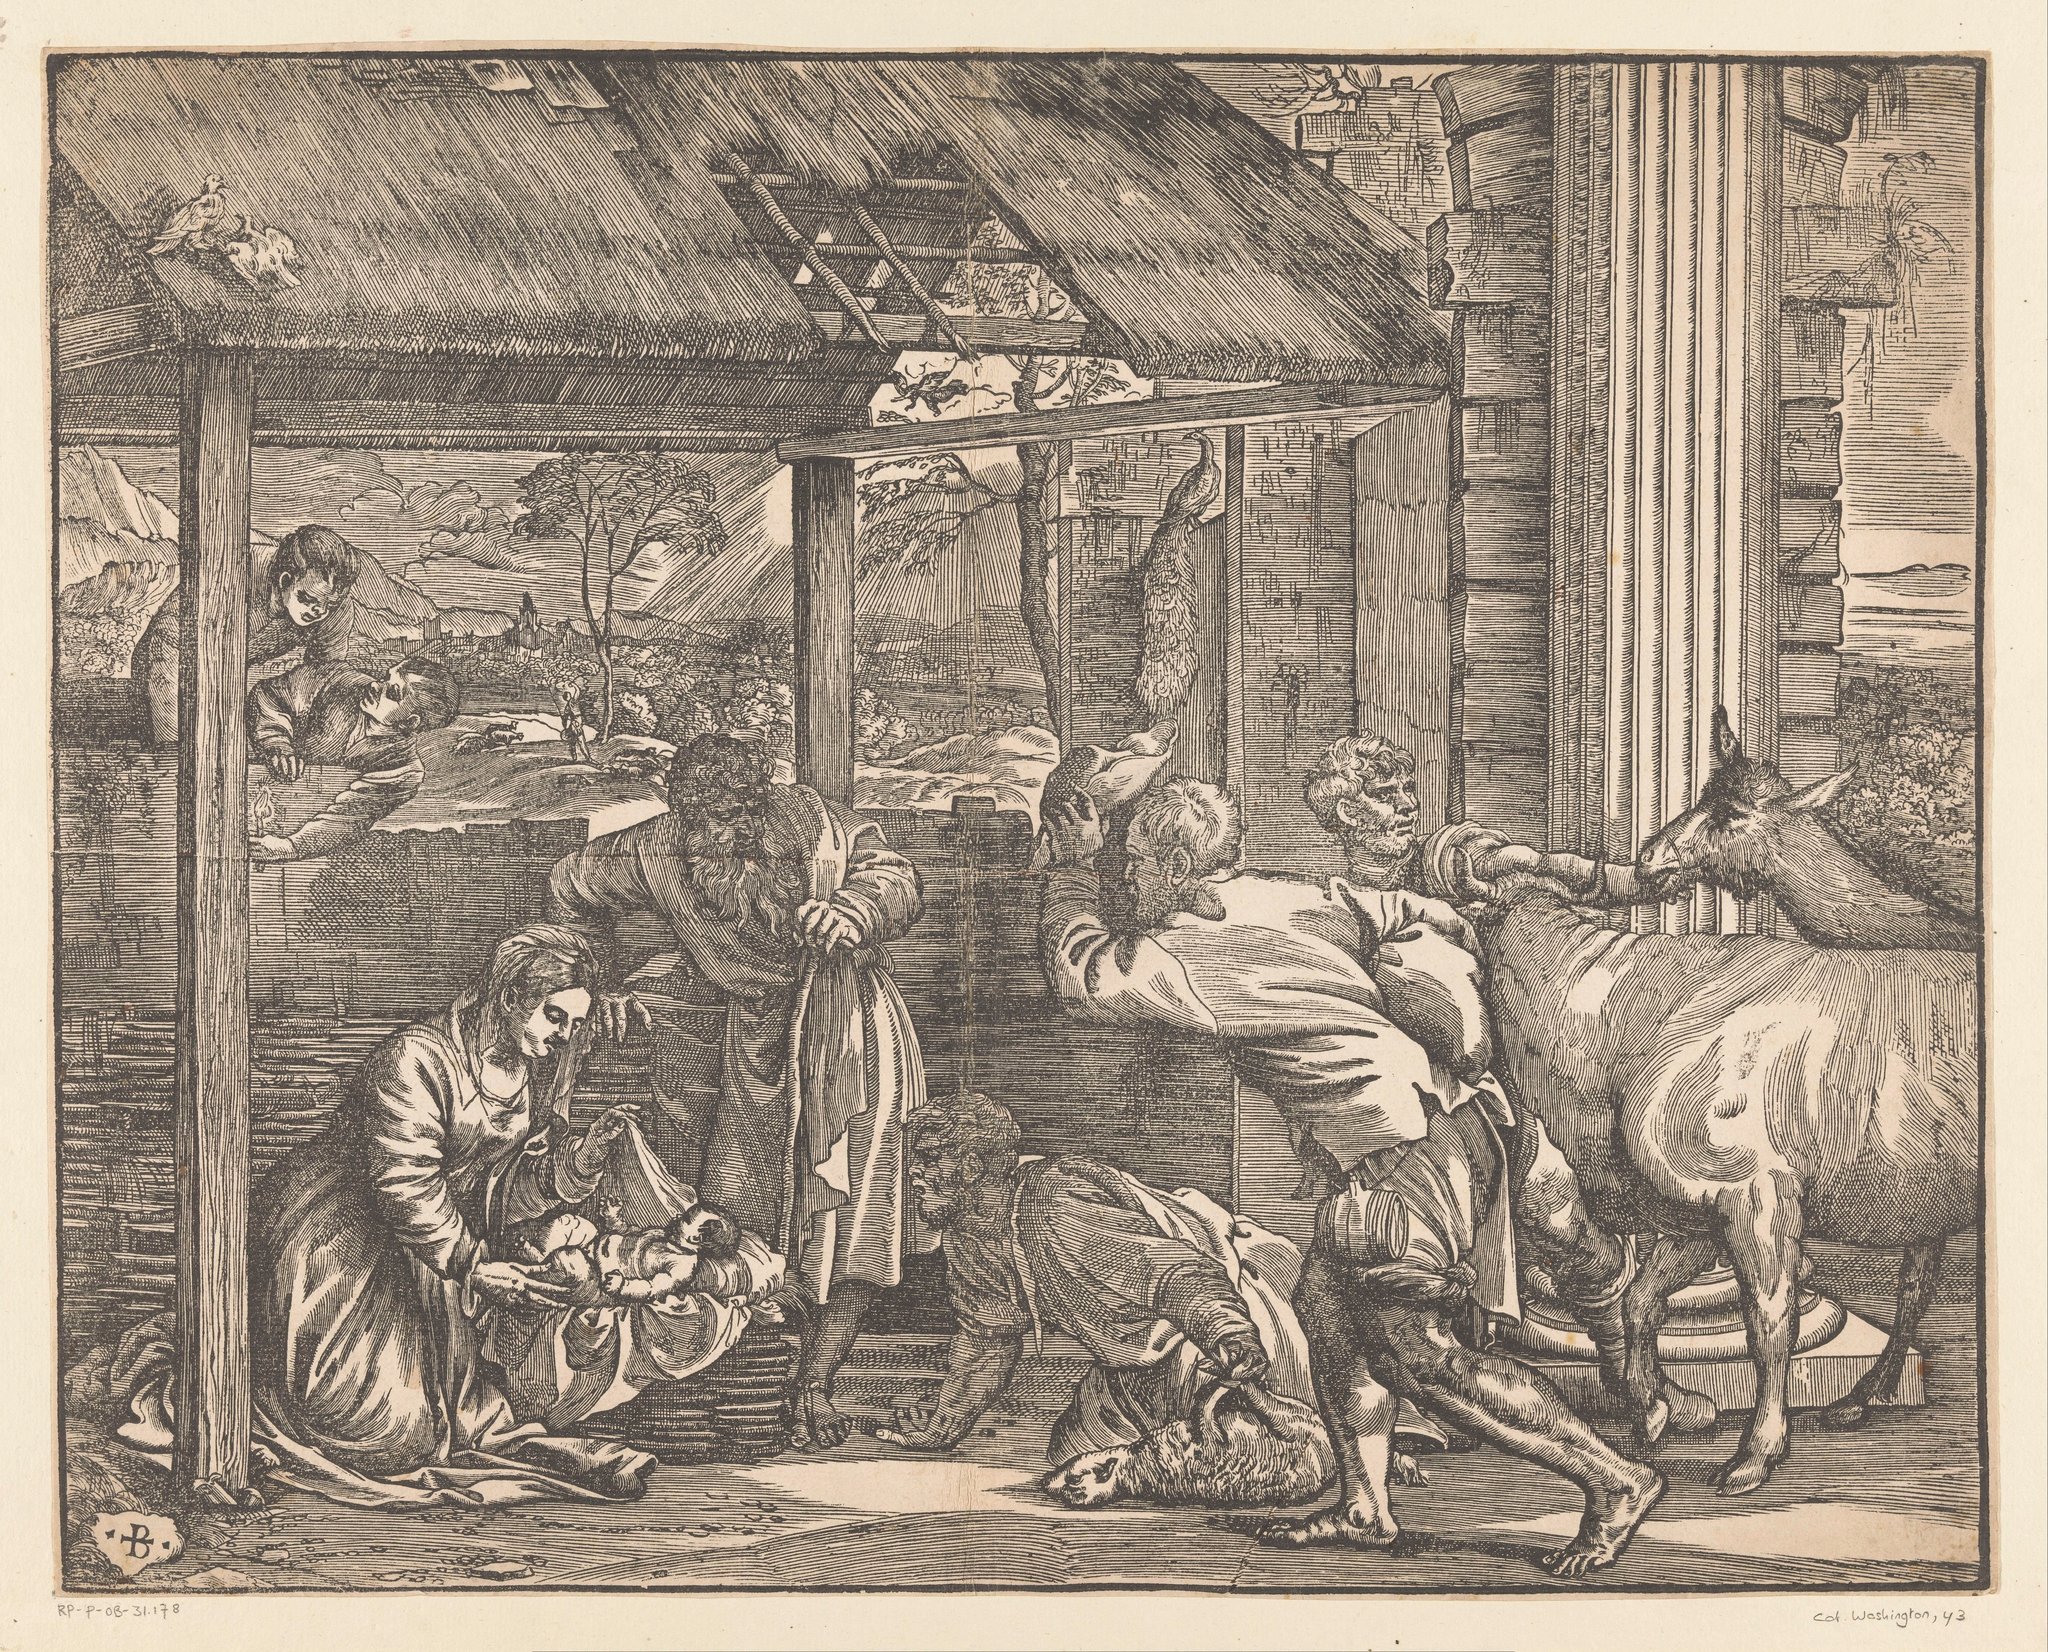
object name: print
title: Aanbidding door de herders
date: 1535-1540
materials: ink, paper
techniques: pen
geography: venice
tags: city-view, and landscape with man-made constructions, adoration of the christ-child by the shepherds; mary and joseph present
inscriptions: collector's mark: Lugt 240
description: Onder een afdak aanbidden de herders het Christuskind dat in een kribbe ligt. Bij het Kind staan Maria en Jozef. Links twee jongens en op de achtergrond een landschap.